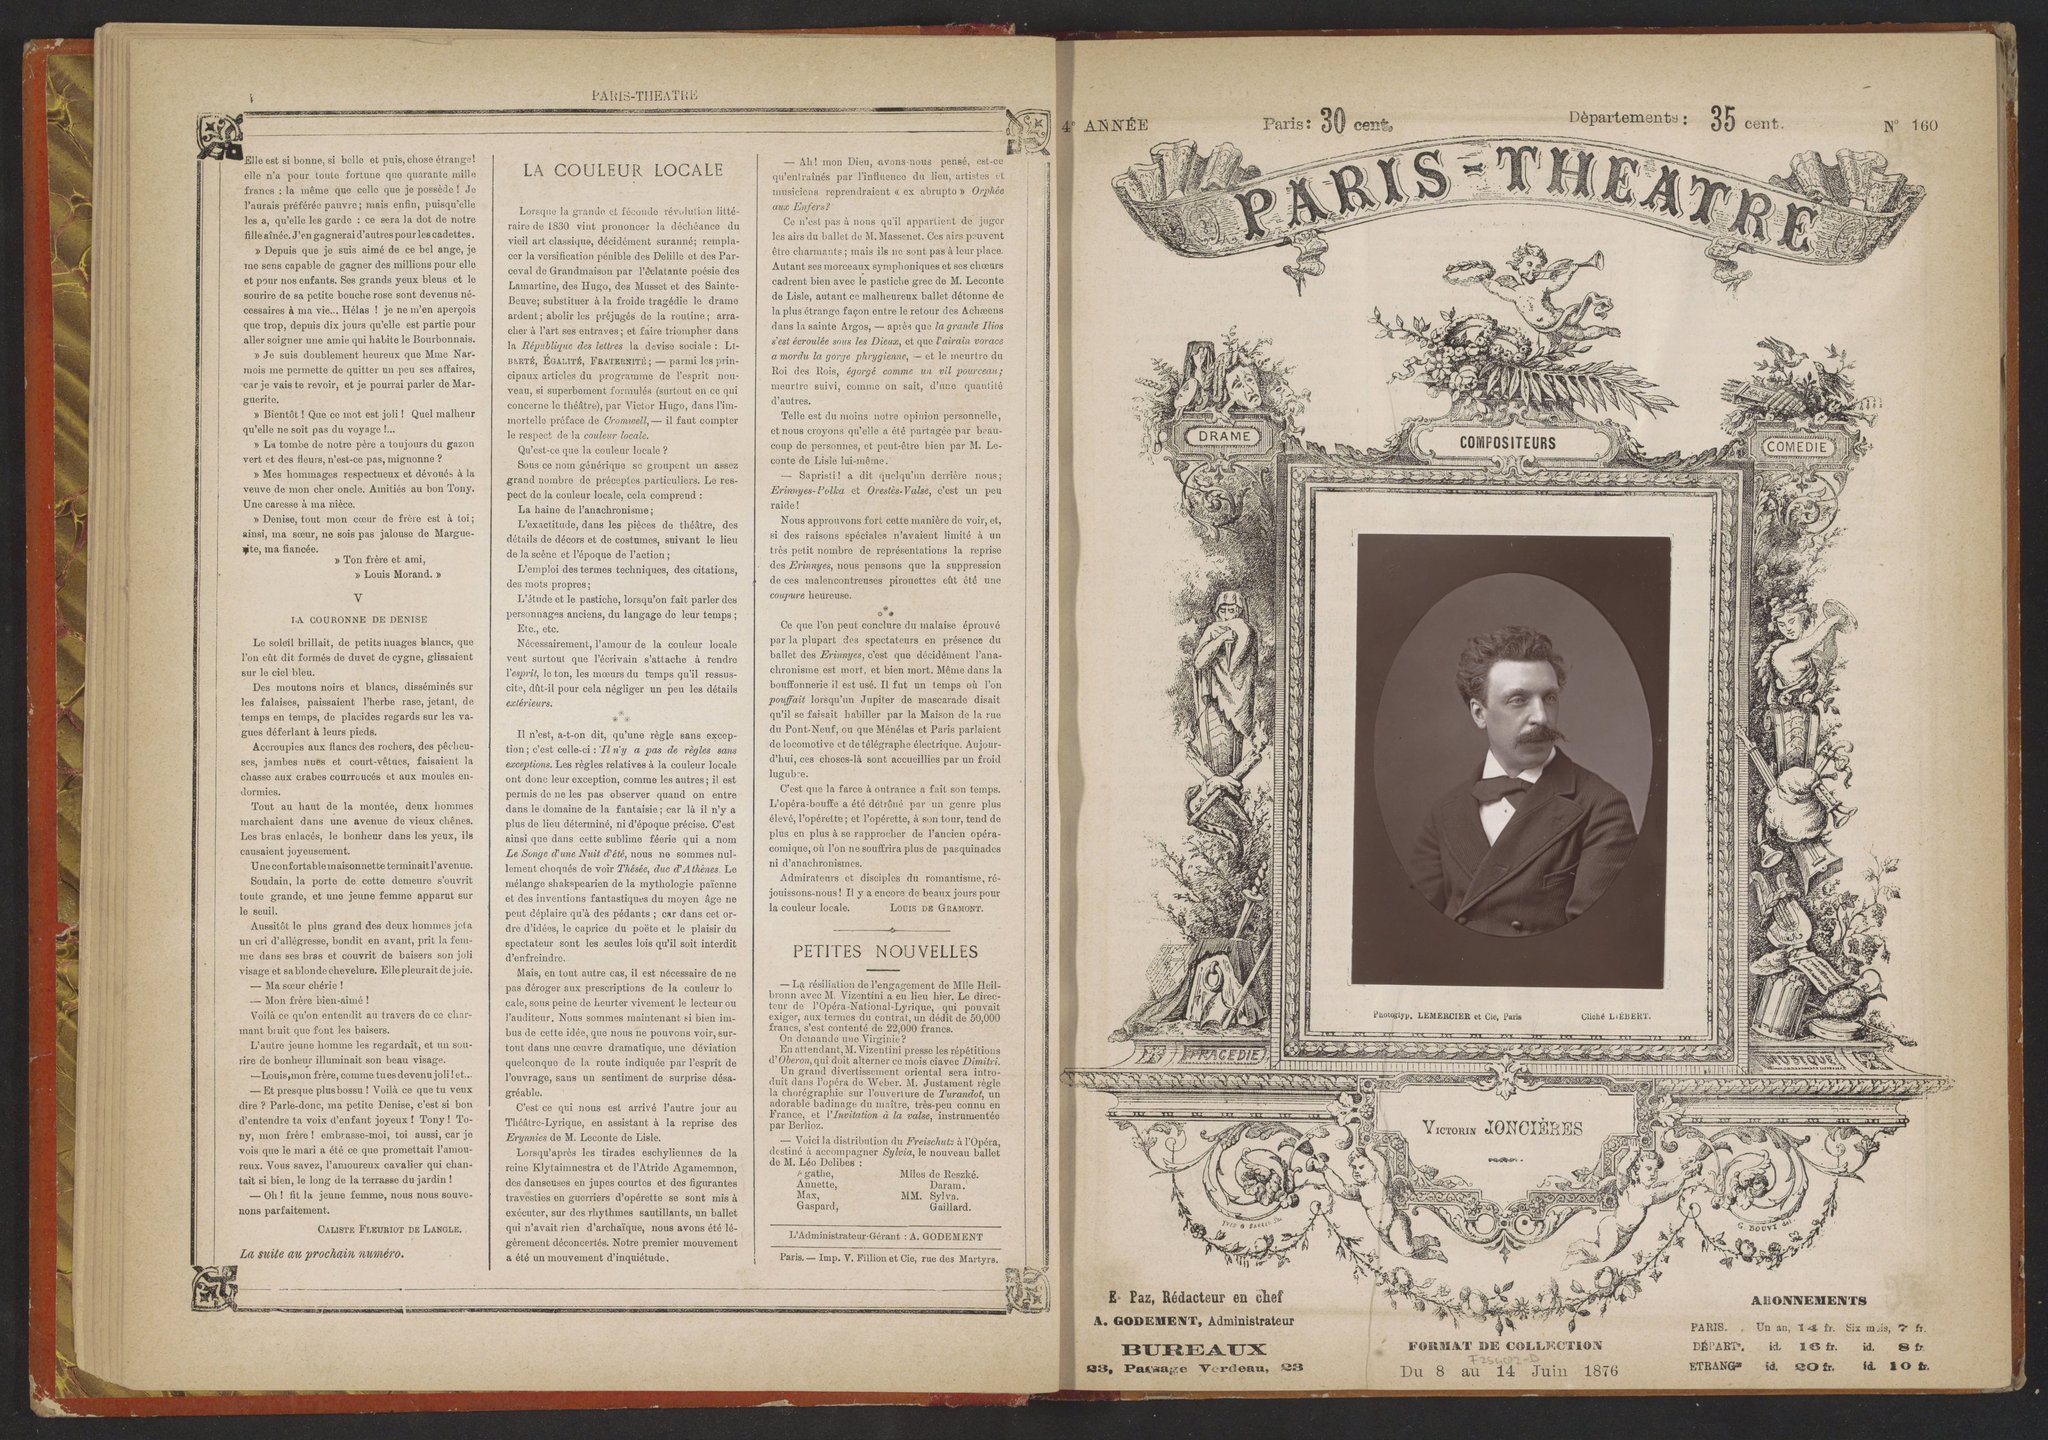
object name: page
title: Victorin Joncières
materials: paper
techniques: woodburytype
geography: france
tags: composer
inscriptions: number: ‘No 160’, inscription: ‘Du 8 au 14 Juin 1876’